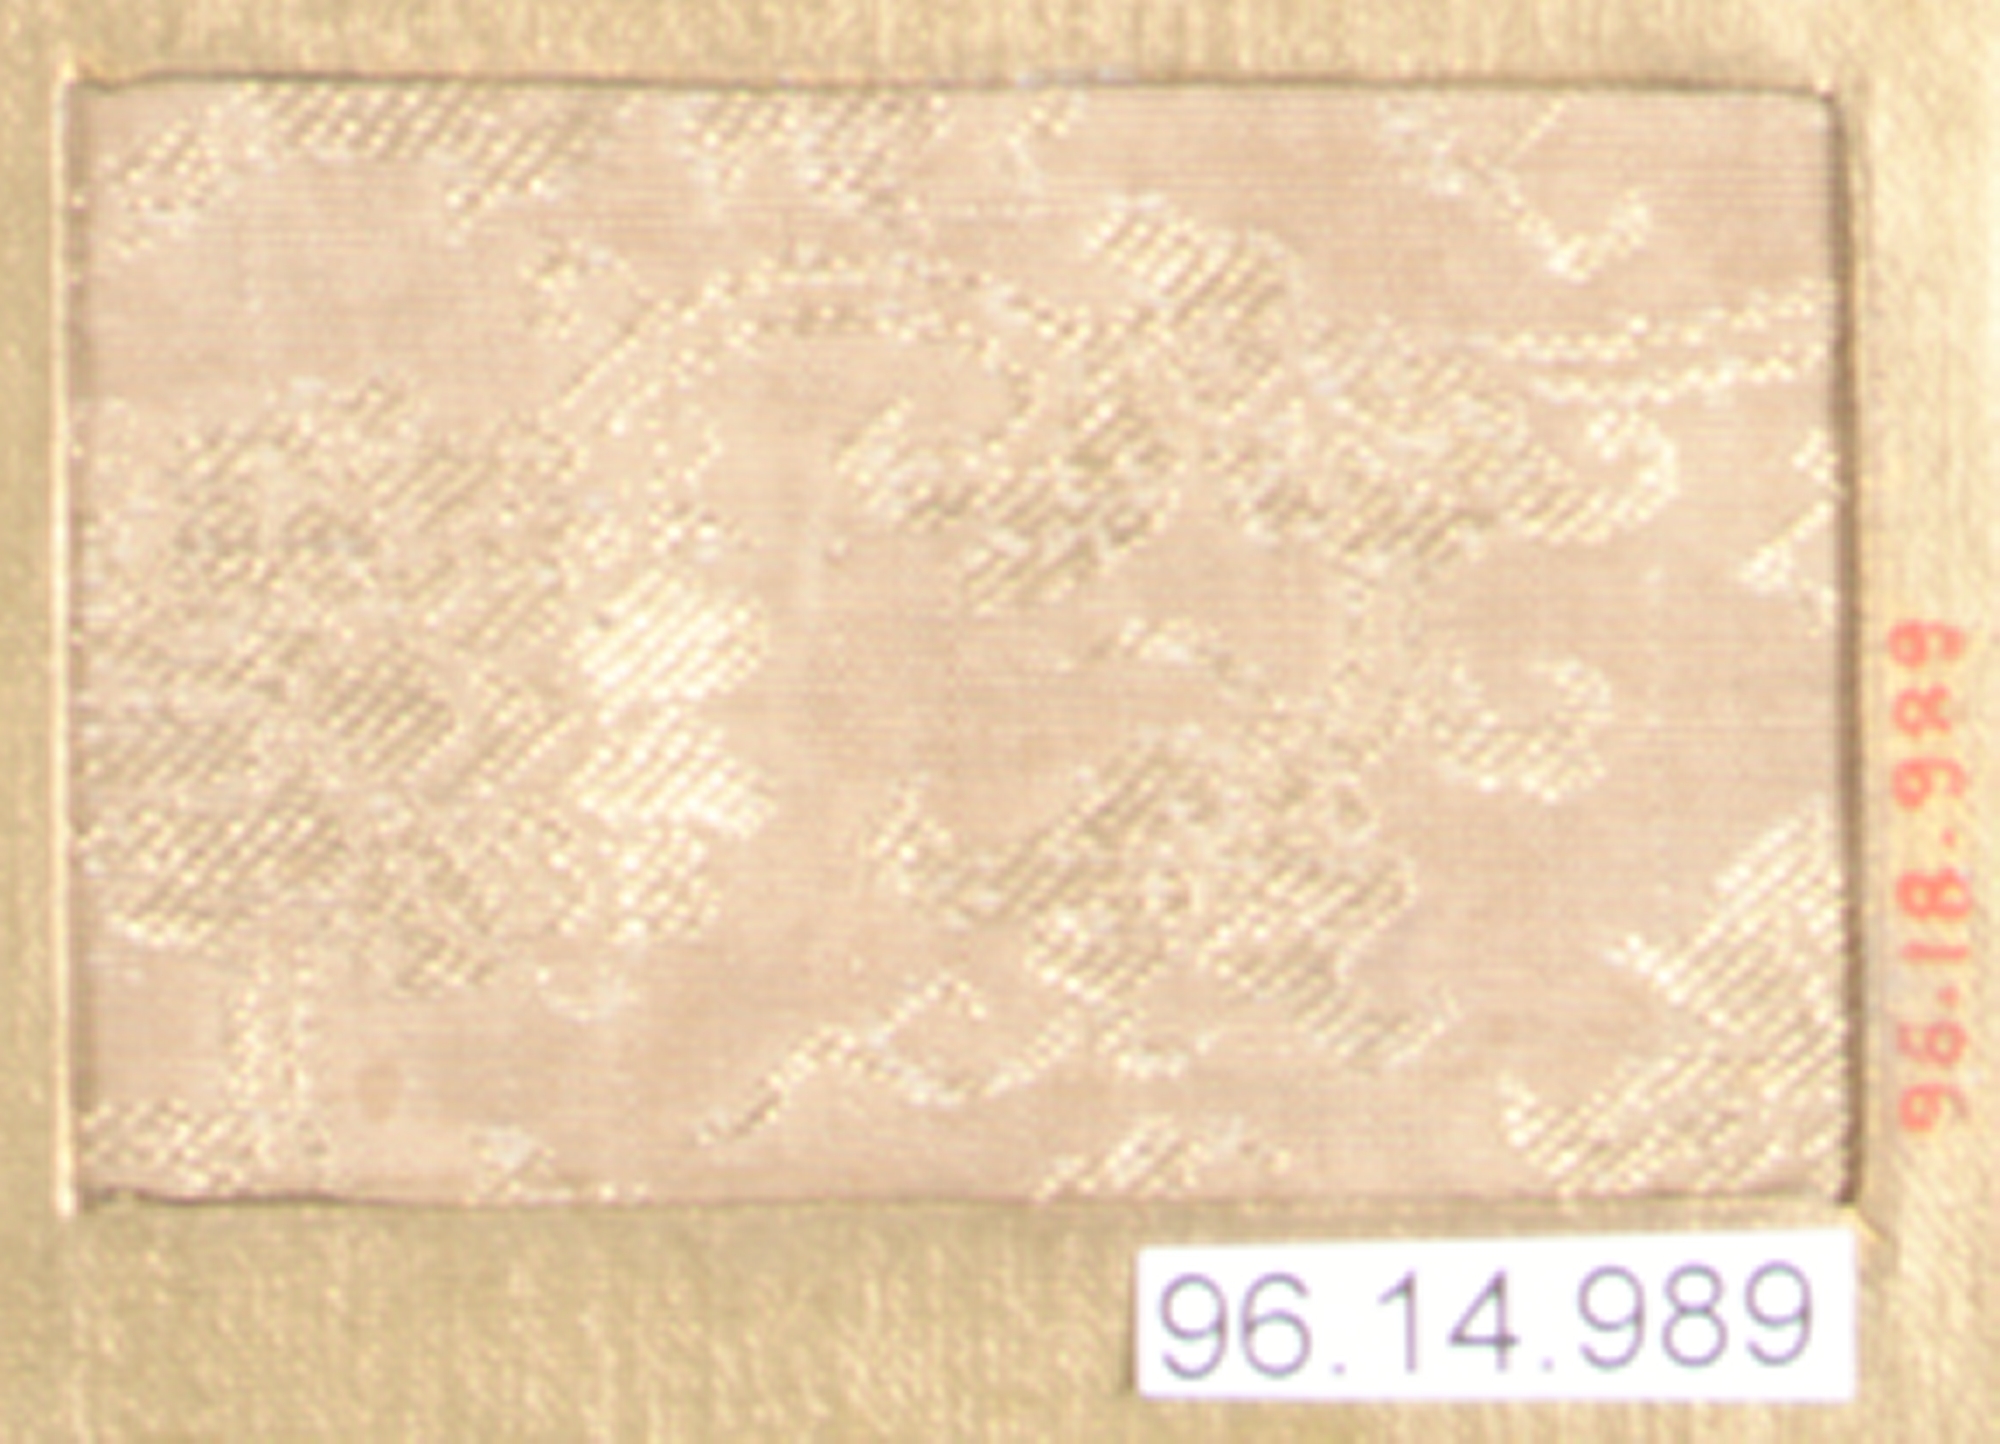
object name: piece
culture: japanese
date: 1701-1900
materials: silk